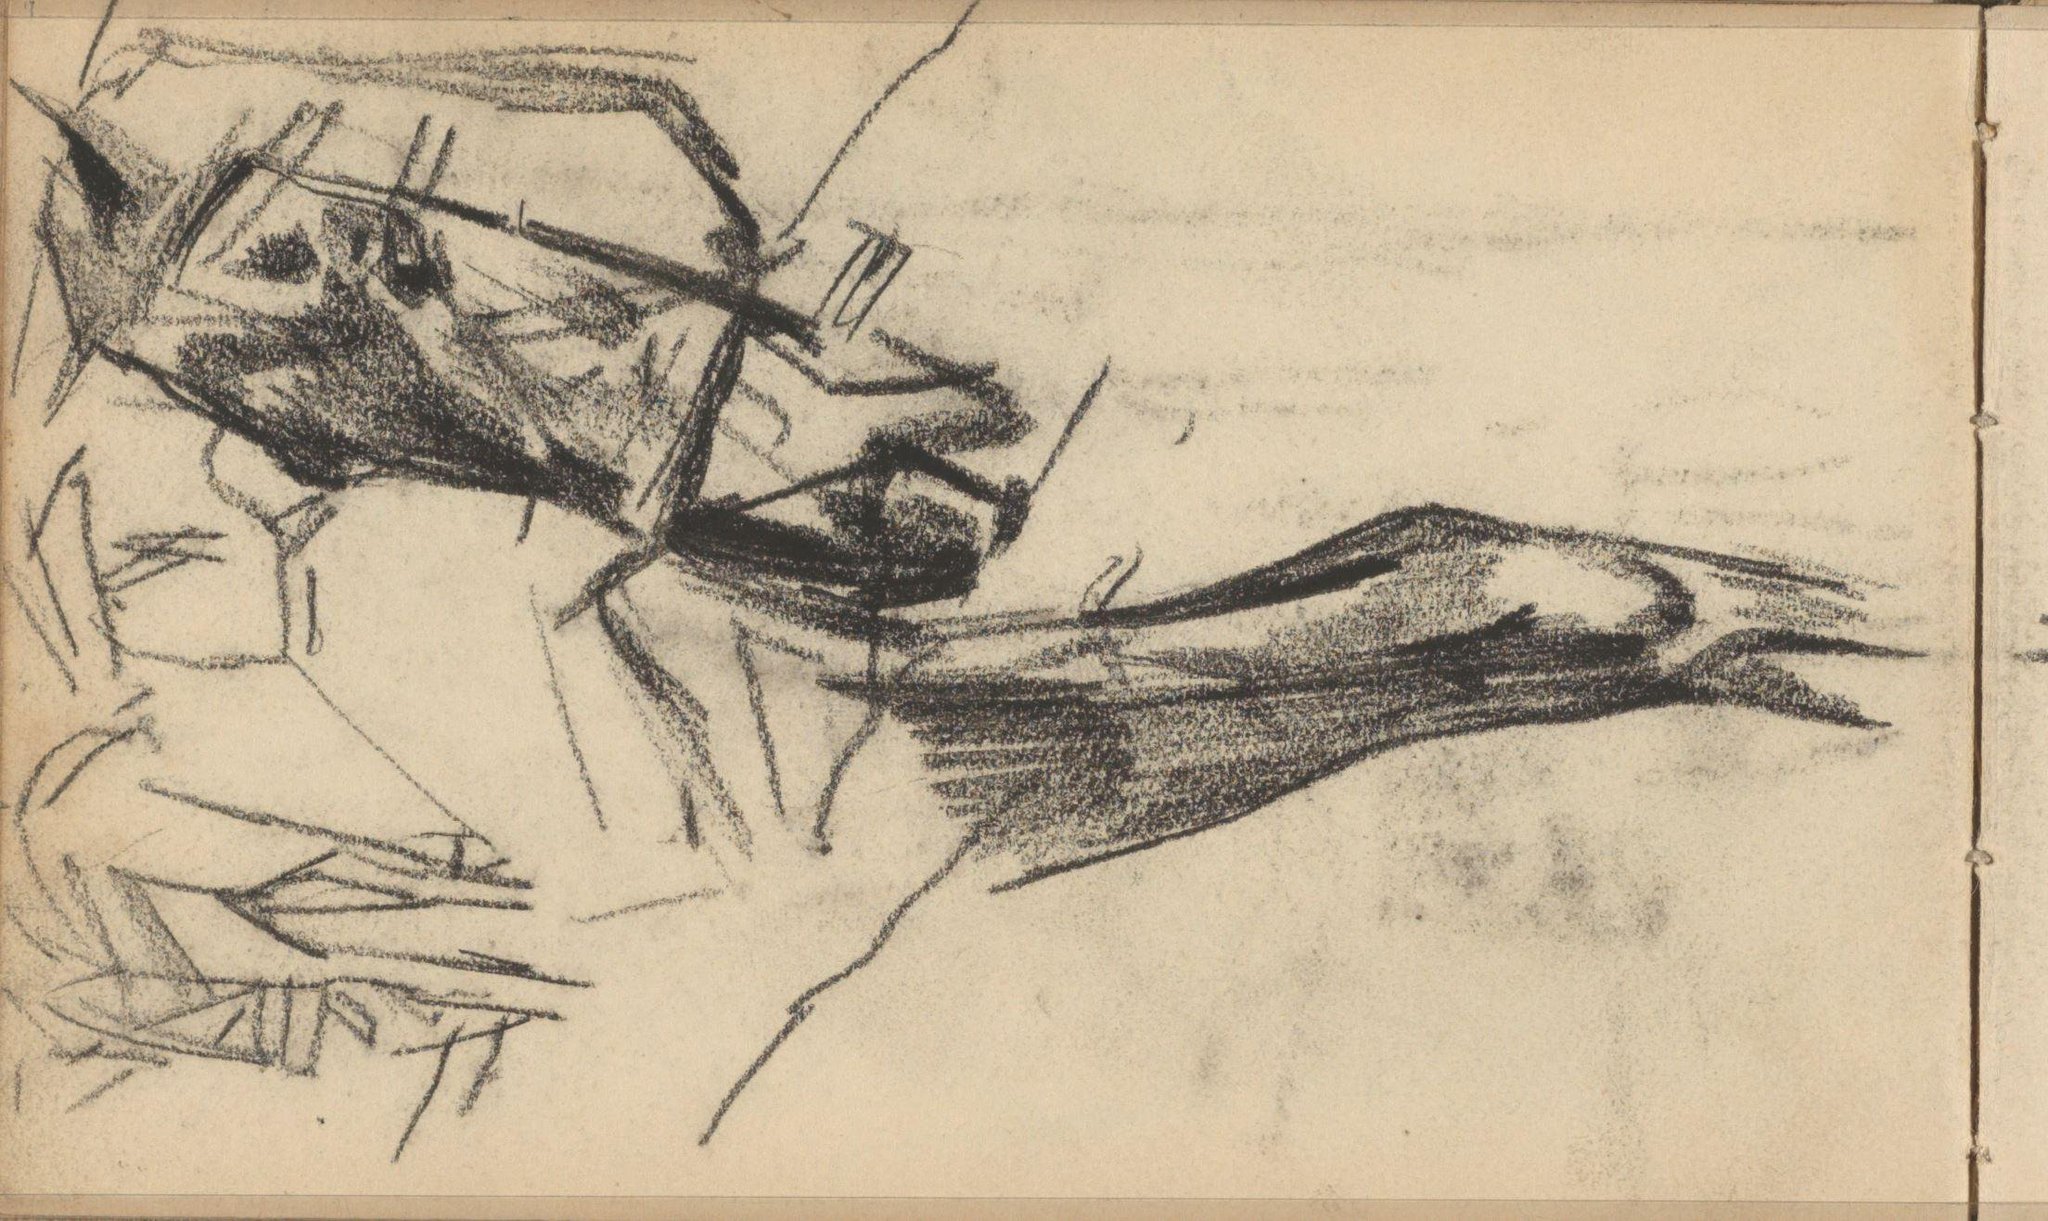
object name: sketchbook leaf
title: Paarden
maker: george hendrik breitner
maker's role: draughtsman, painter, print maker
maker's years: 1857-1923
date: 1884-1886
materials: chalk, paper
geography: the hague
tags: horse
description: Pagina 17 uit een schetsboek met 35 bladen.